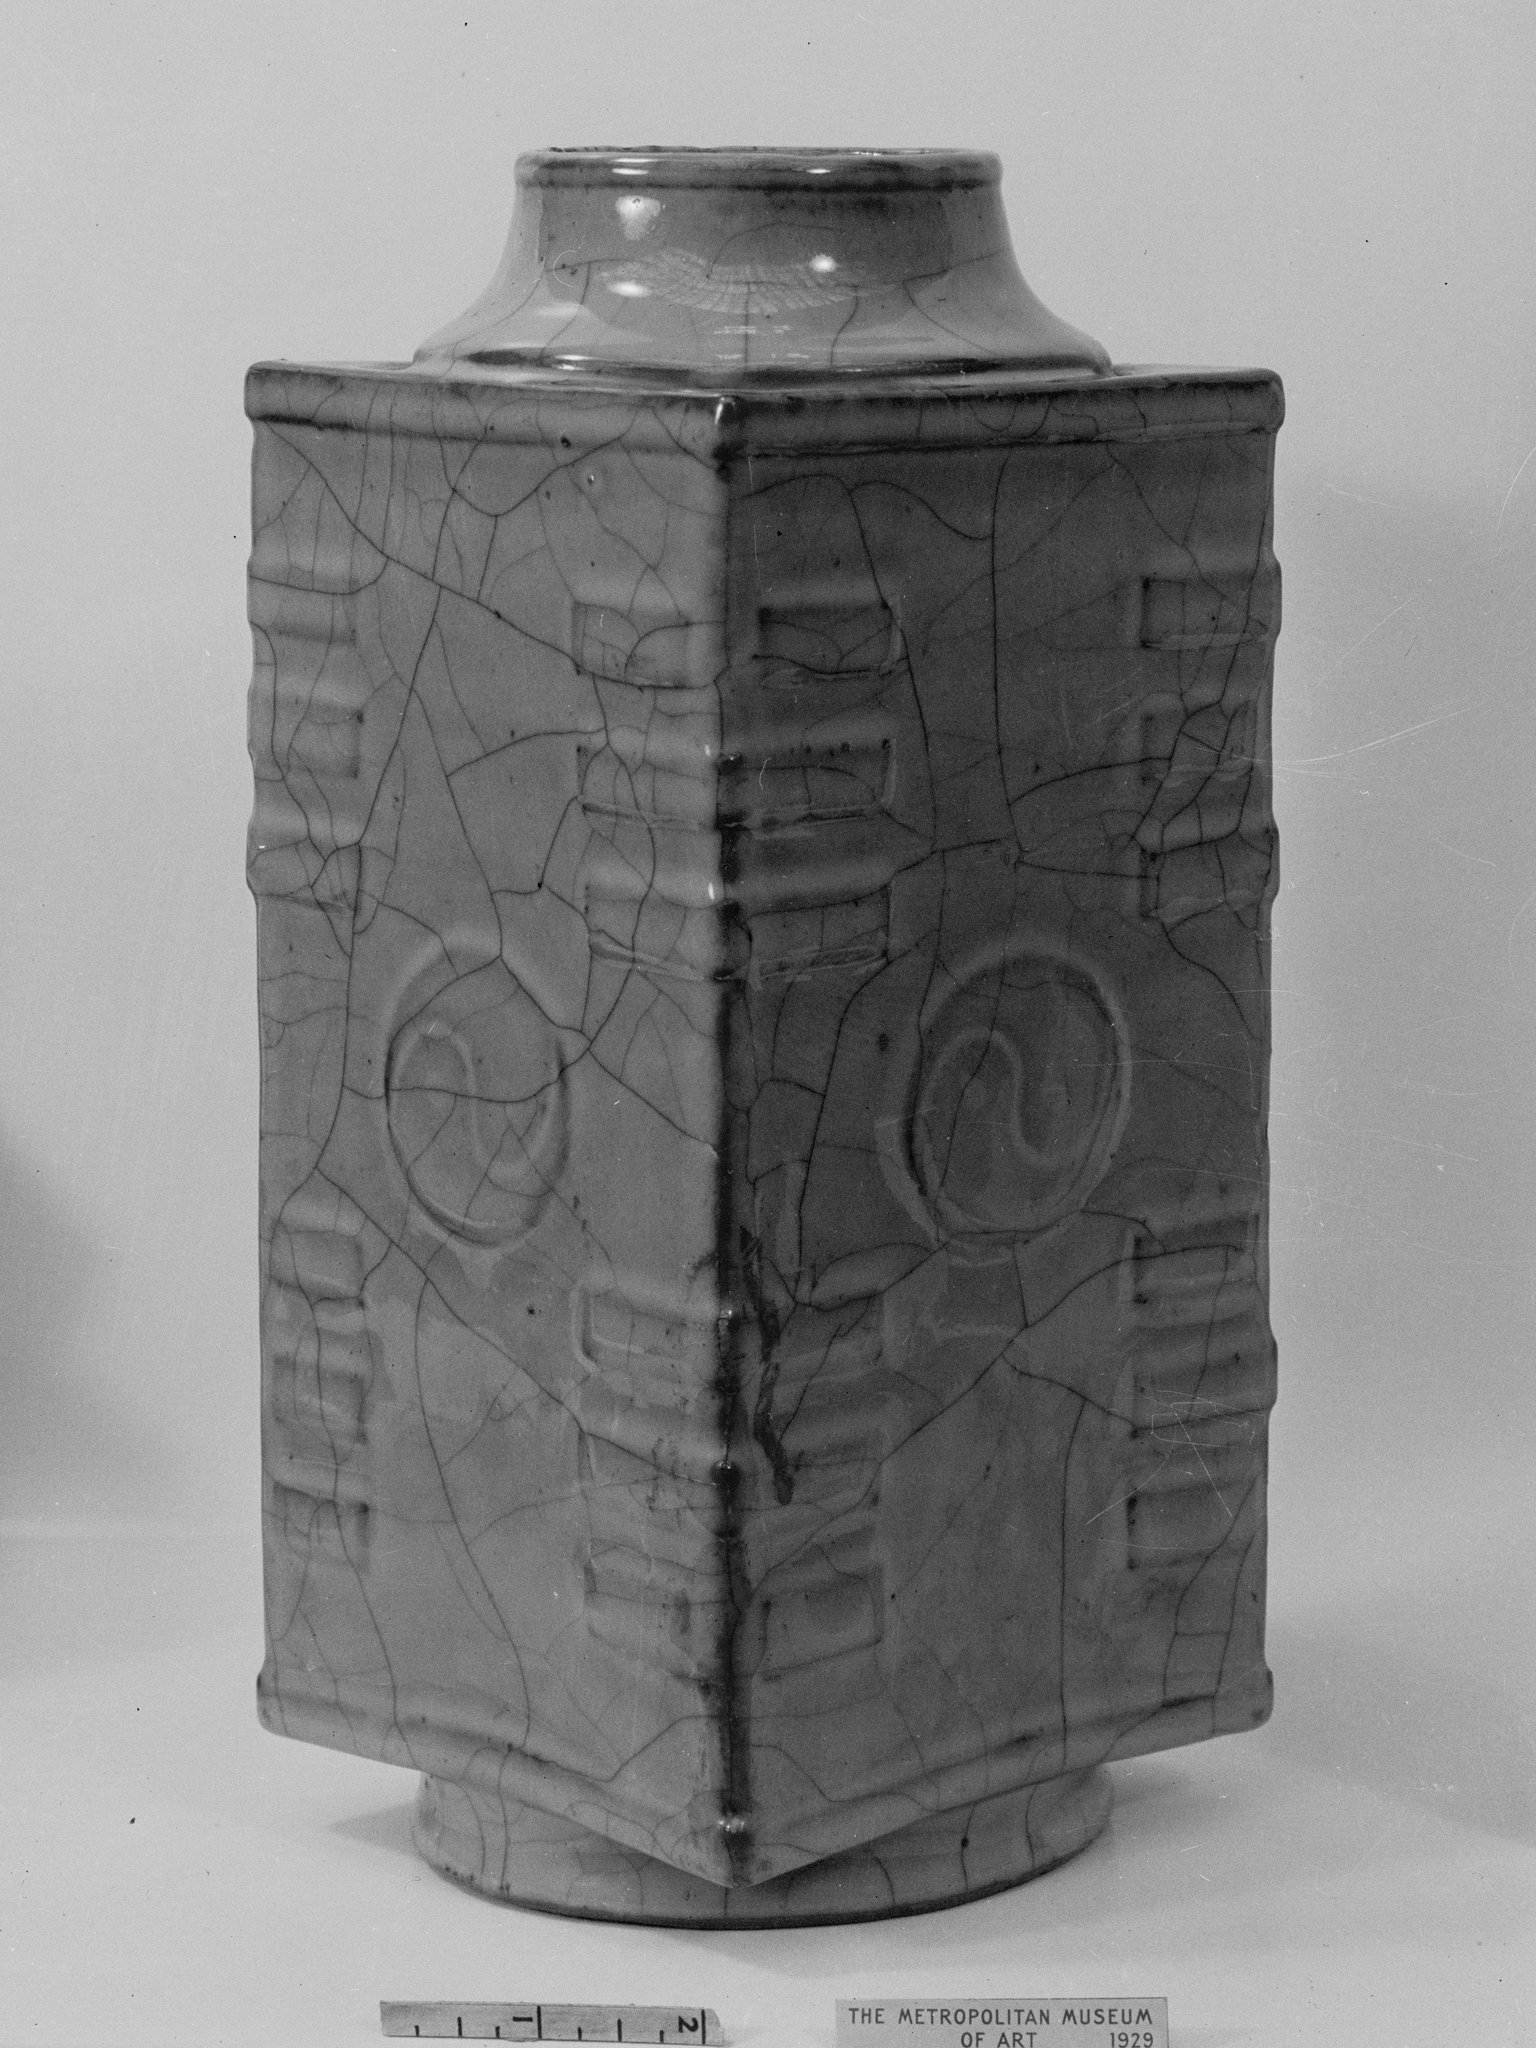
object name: vase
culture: chinese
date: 1723-1795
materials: ceramic glaze, glaze, porcelain